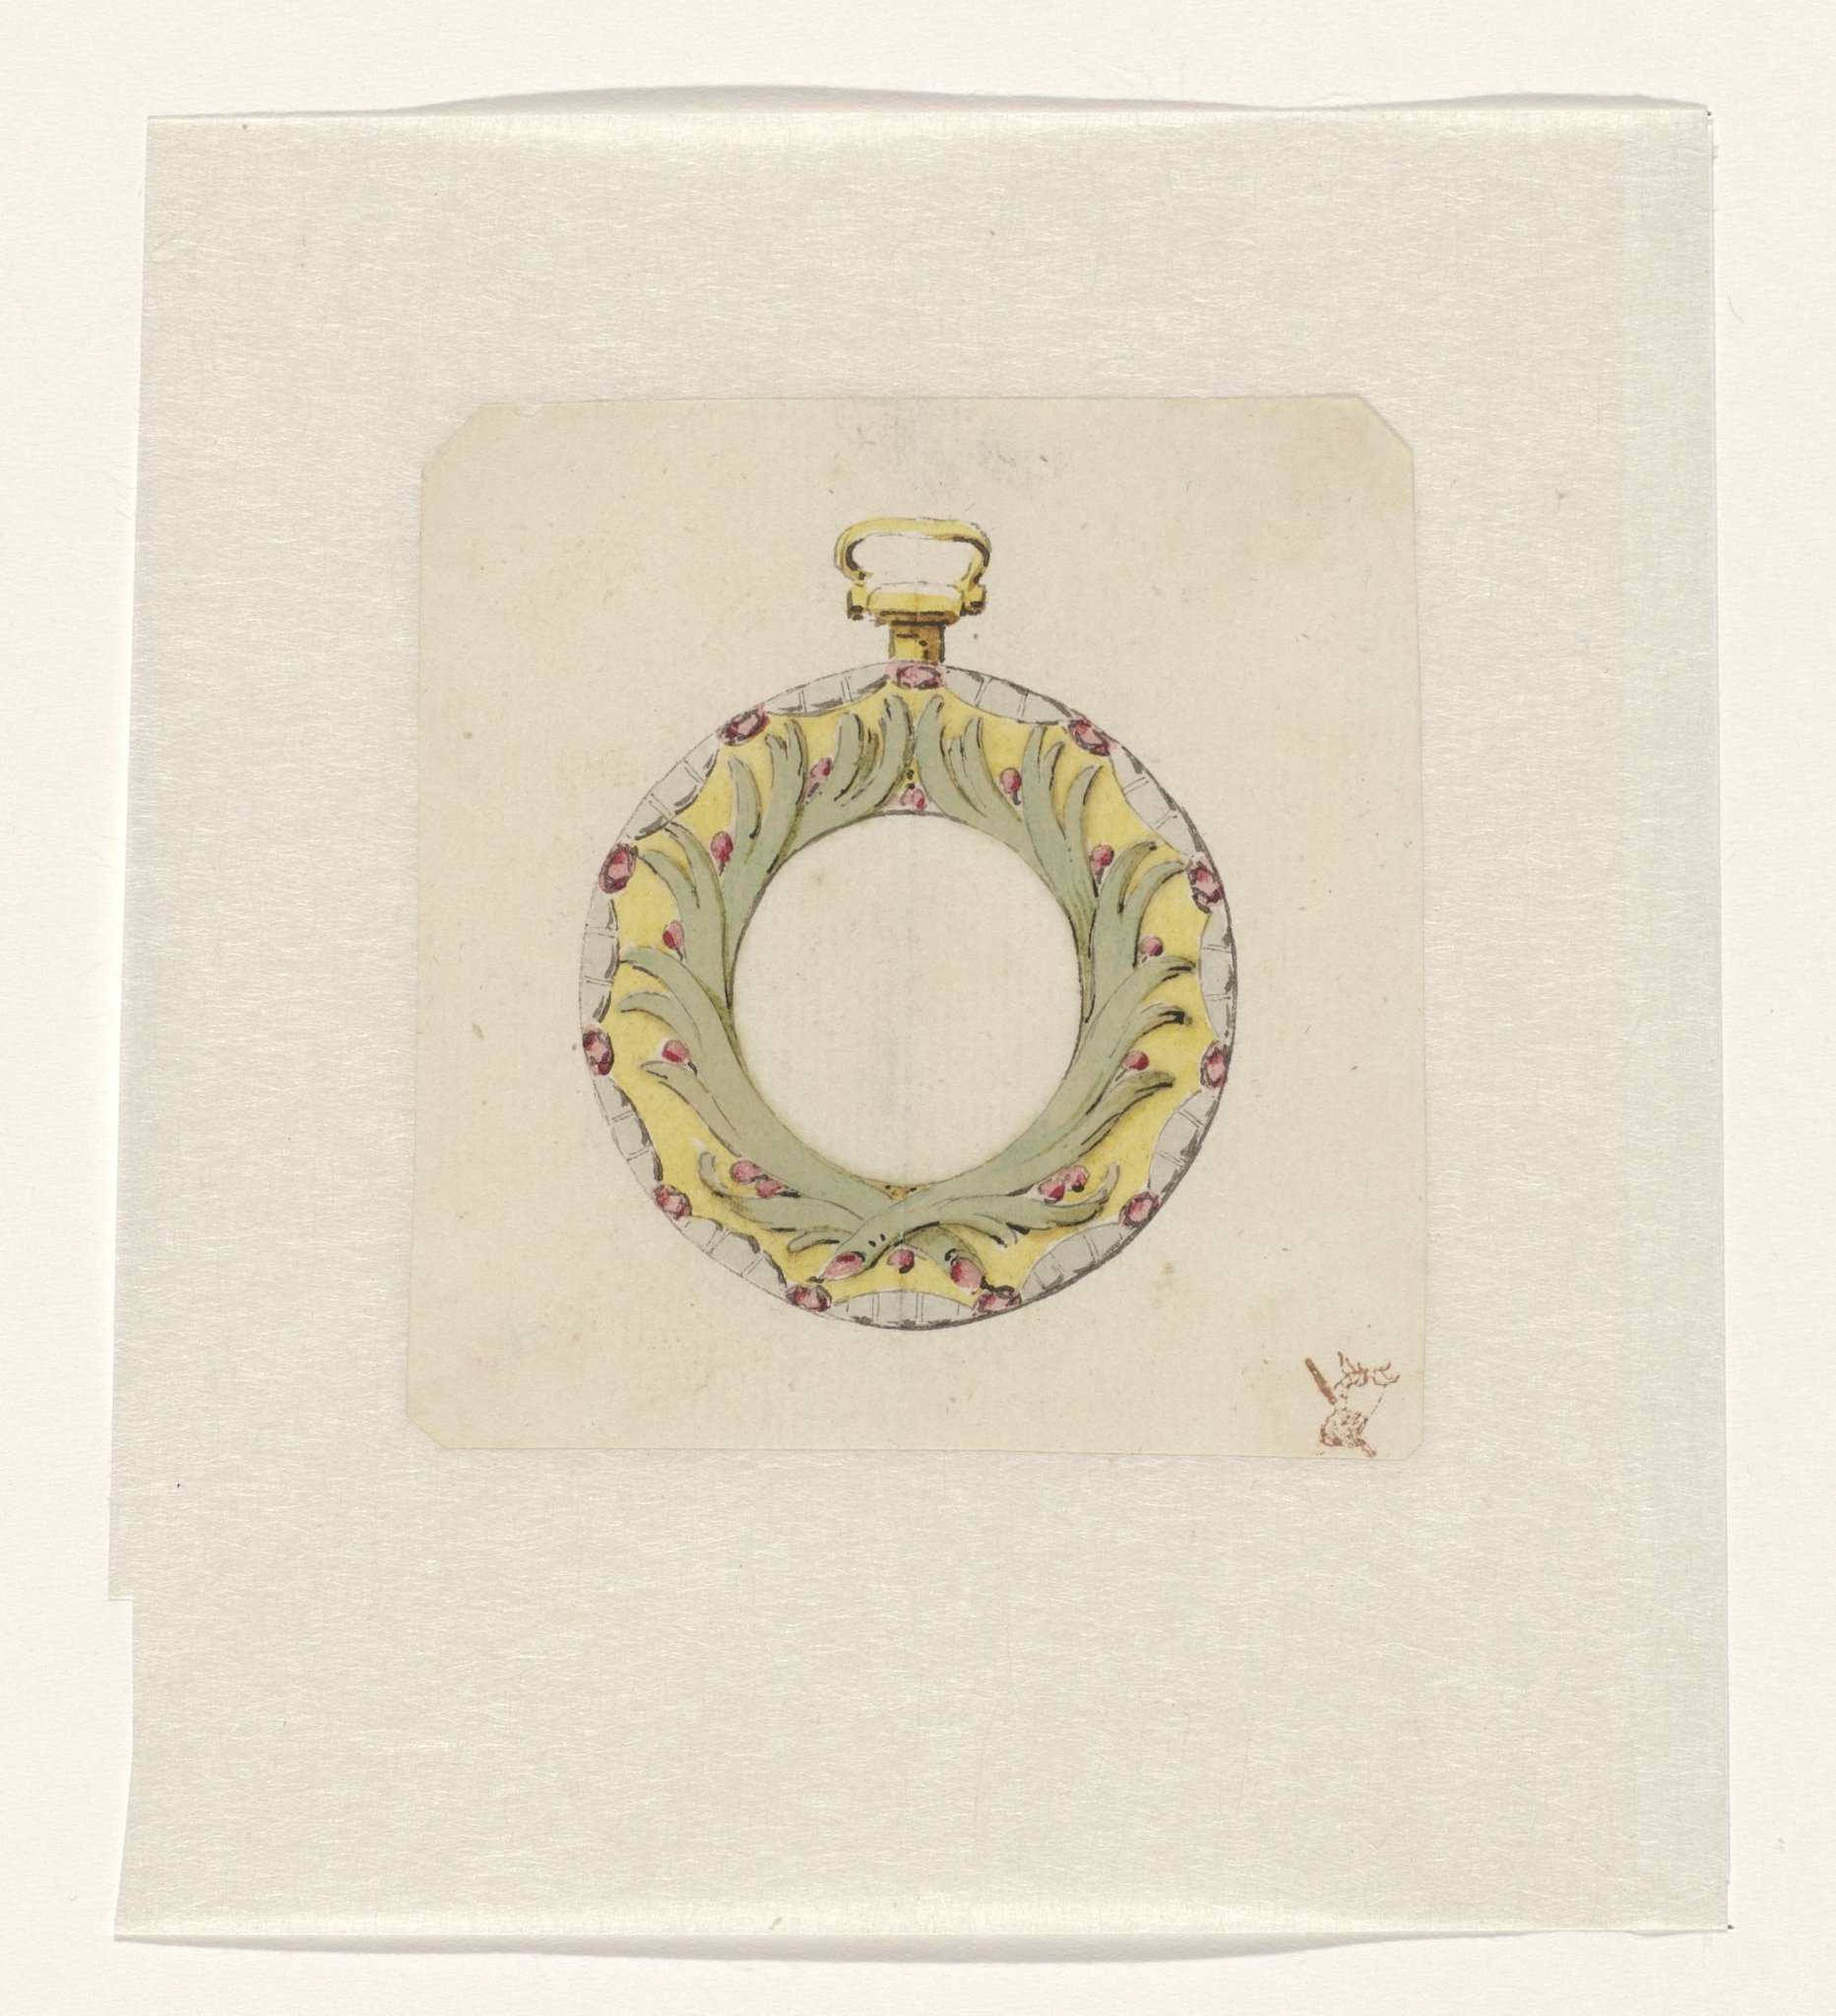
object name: drawing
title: Two designs for watch-cases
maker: Anonymous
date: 1765-1780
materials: ink, paper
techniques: brush, pen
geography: paris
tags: watch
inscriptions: collector's mark: Lugt 3893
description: The watch-cases were intended to be executed in enamelled gold, probably set with rubies and diamonds. An enamel picture could be mounted at the centre. These are probably presentation drawings. A goldsmith or merchant would show them to prospective clients for them to choose a pattern.